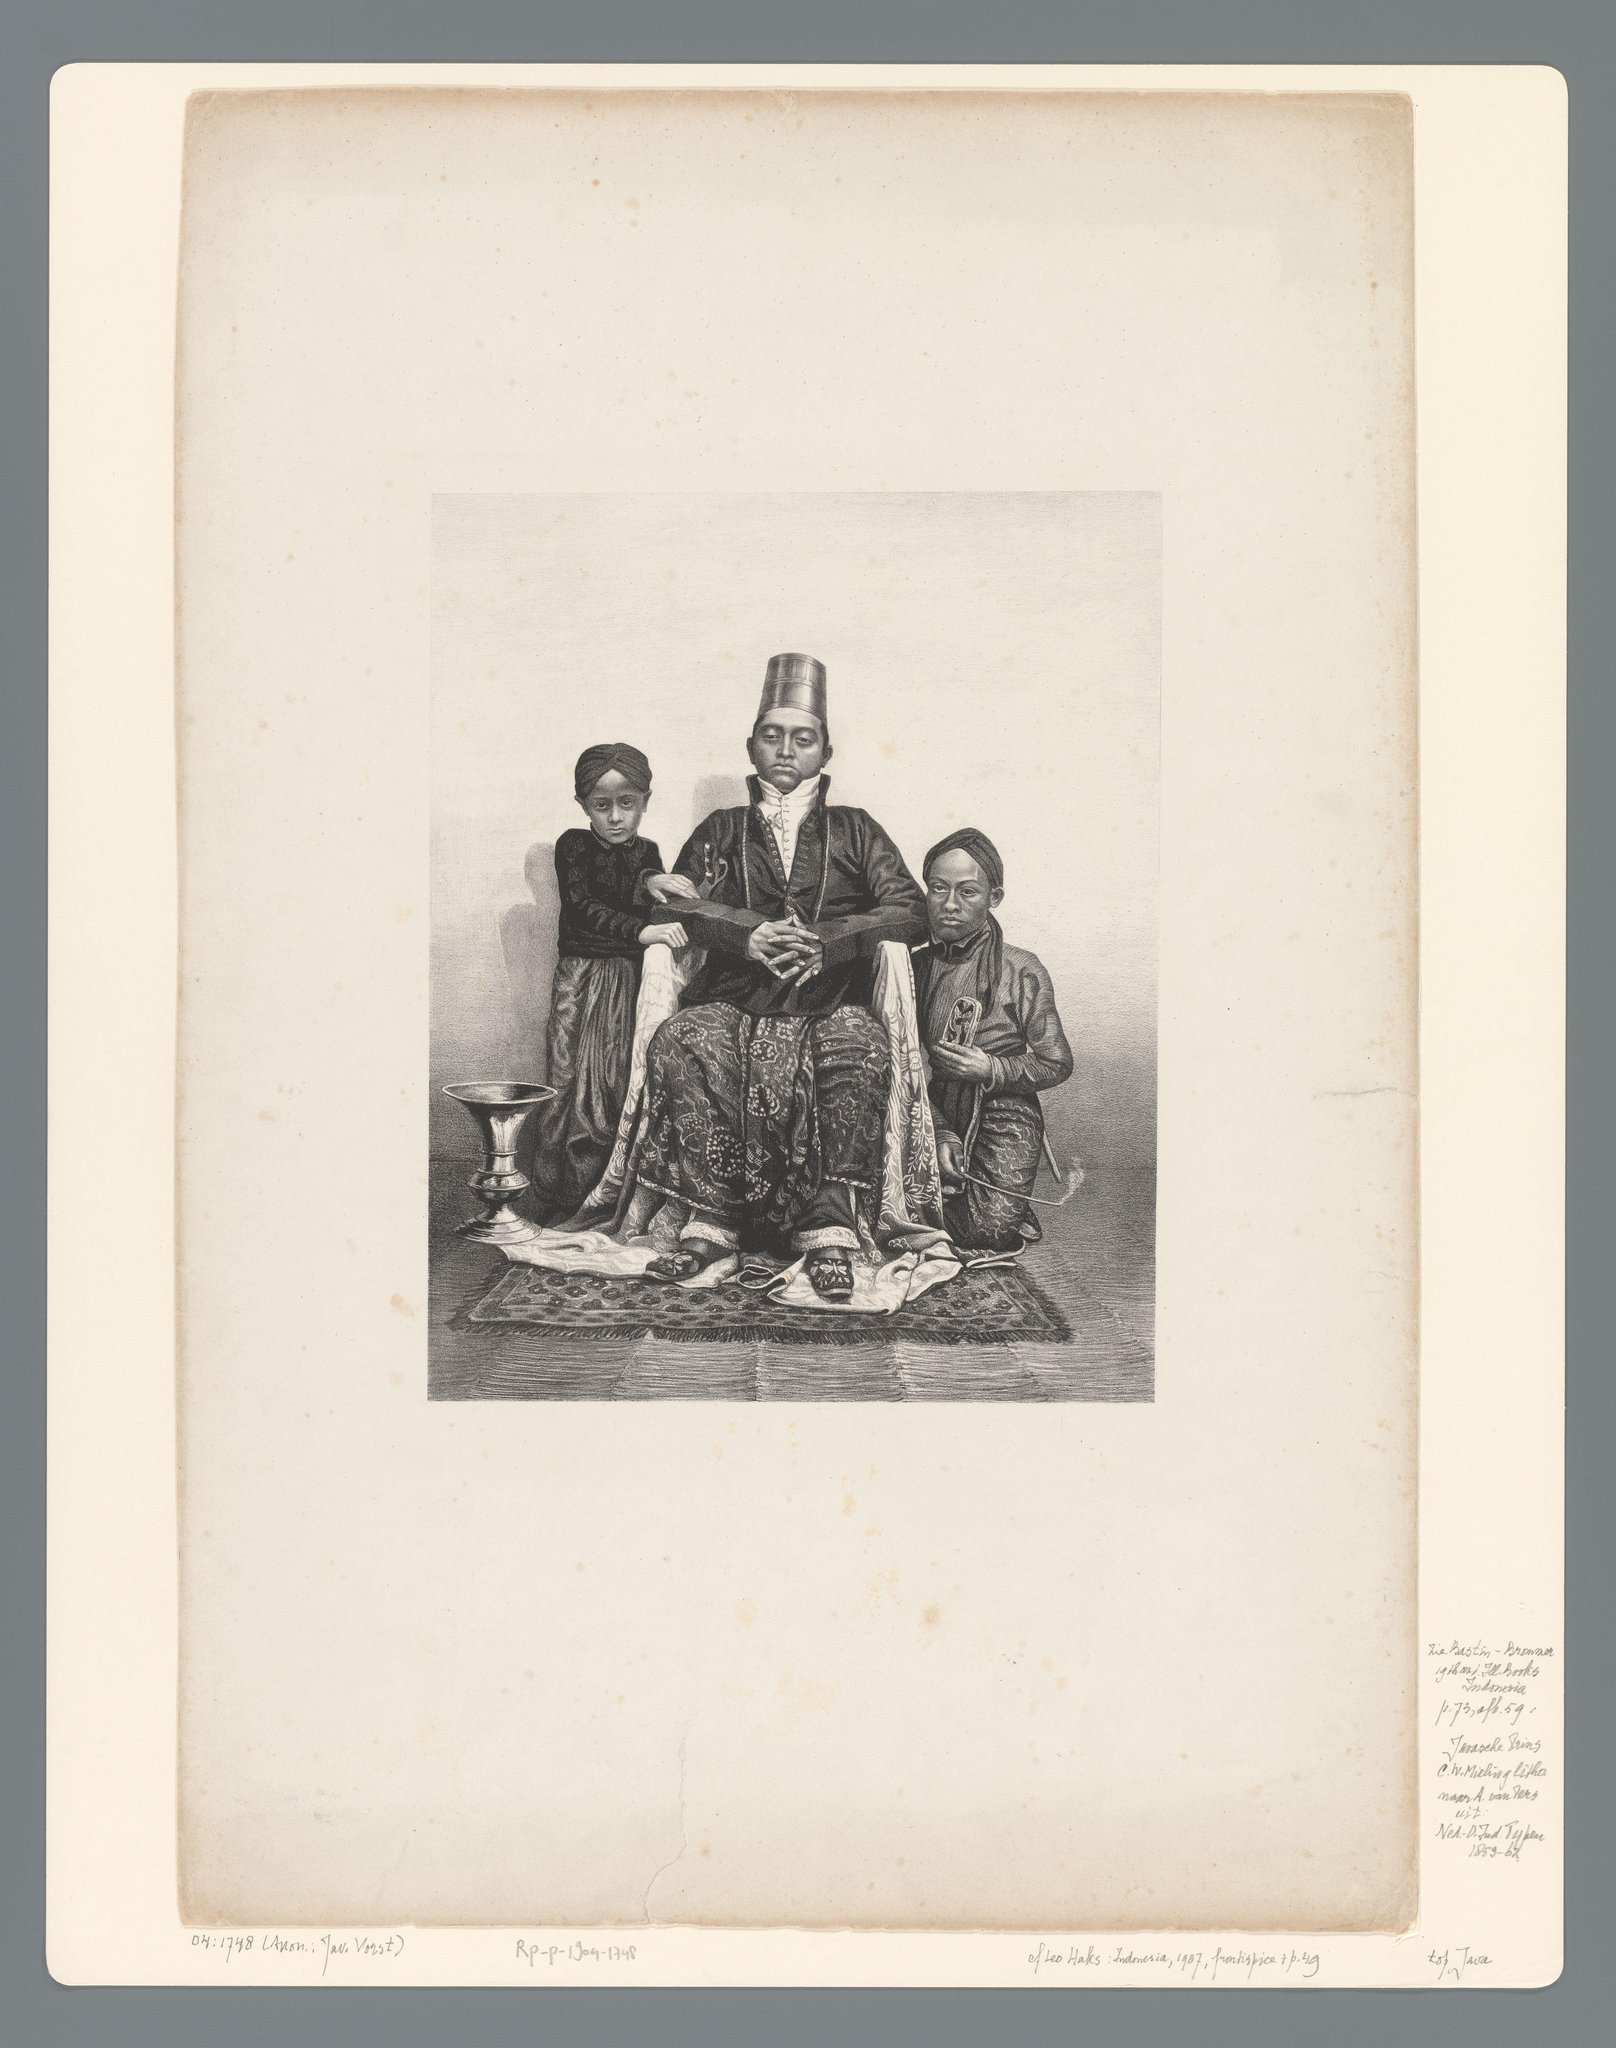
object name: print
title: Javaanse vorst met twee volgelingen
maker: carl wilhelm mieling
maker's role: print maker, printer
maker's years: 1815-1903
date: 1854-1856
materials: paper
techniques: lithograph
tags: ruler, sovereign, incense-burner ~ scents, perfumes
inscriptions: collector's mark: Lugt 2228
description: Prent ook gebruikt in: Nederlandsch Oost-Indische. Den Haag: Carl Wilhelm Mieling, 1754-1756.